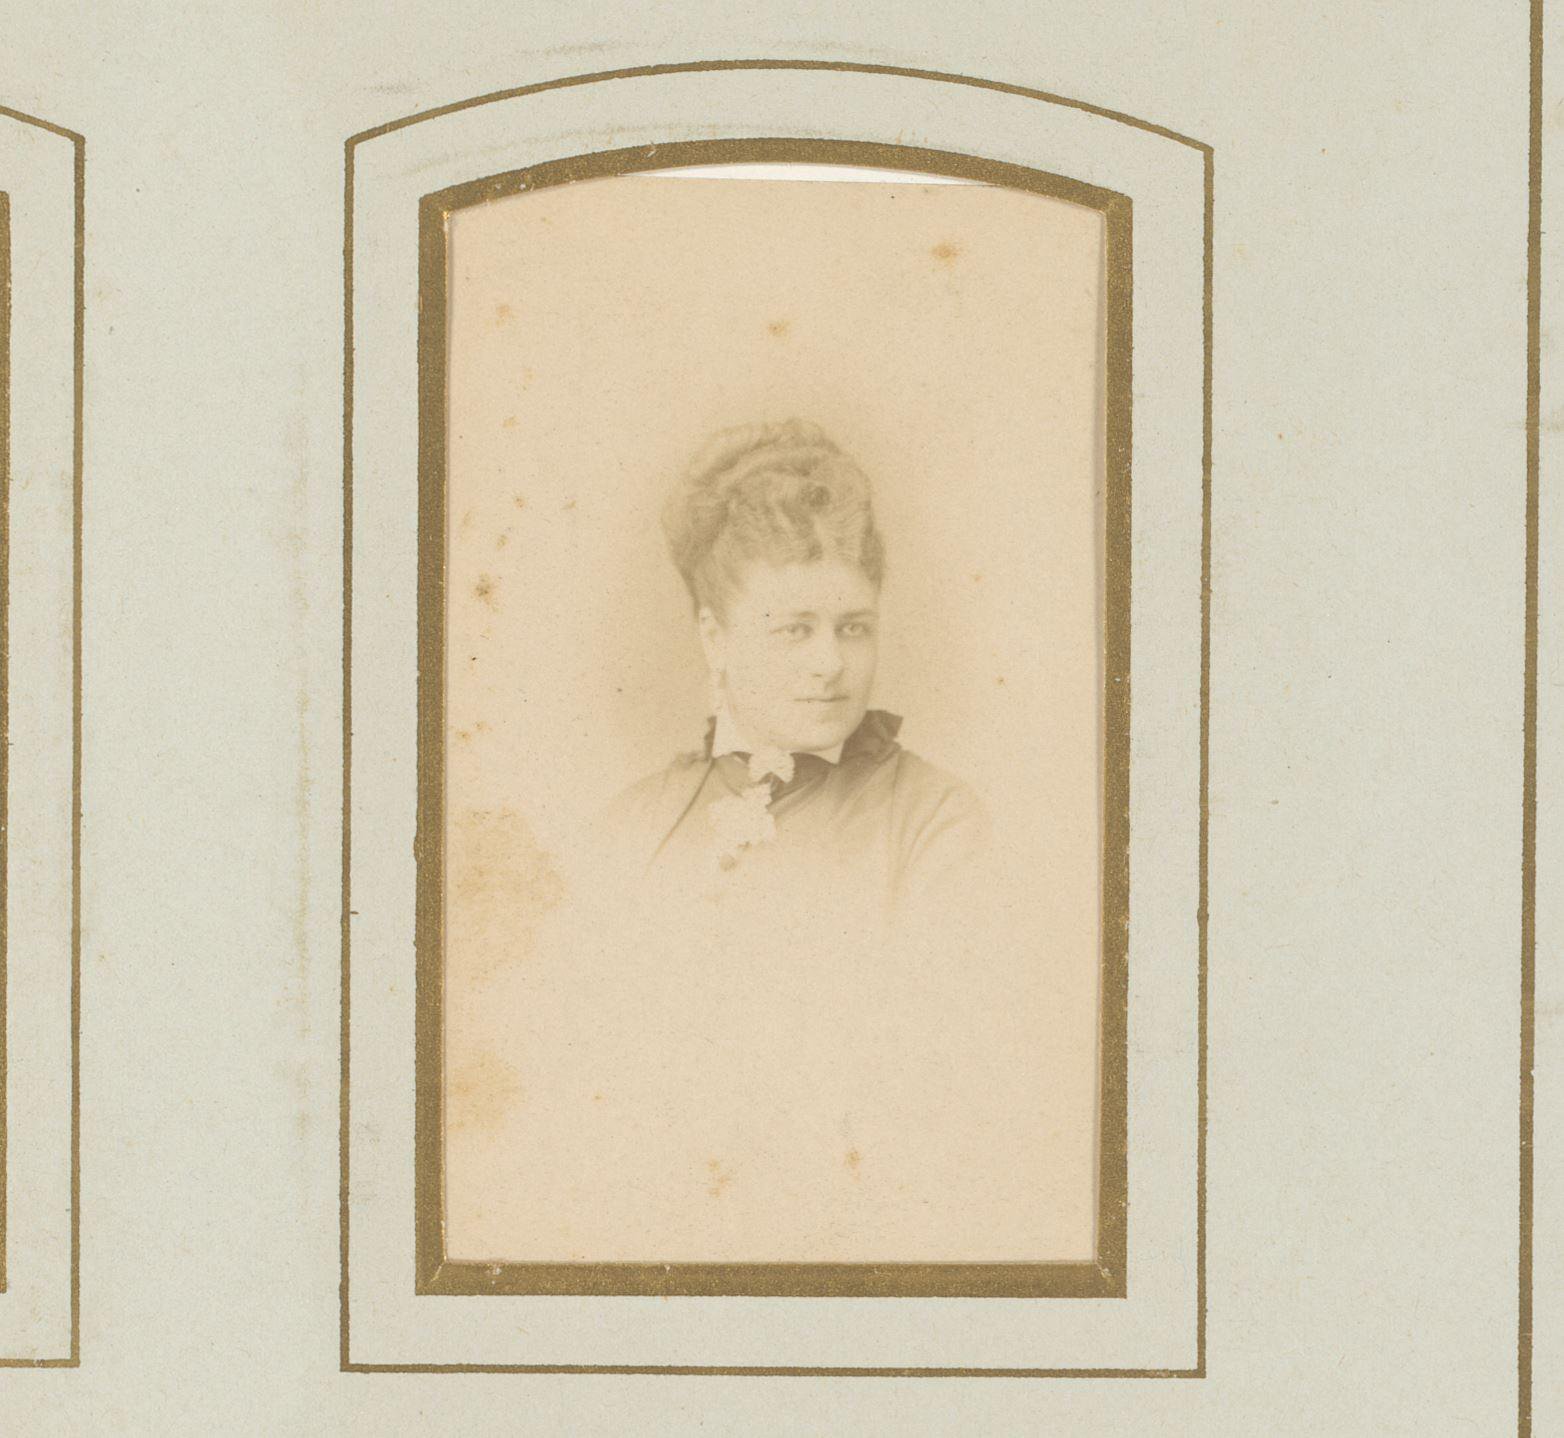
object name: photograph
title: Portret van een vrouw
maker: tony rouge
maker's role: fotograaf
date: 1850-1900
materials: cardboard, photographic support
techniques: albumen print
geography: paris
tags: historical persons - bb - woman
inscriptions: inscription: ‘[...]/ Jules DESREZ Succr/ de/ TONY ROUGE/ 36, Rue Vivienne, 36/ Paris./ A[...] PORT[...]/ Tous les Clichés sont conservés [...]/ des épreuves agrandies jusqu[...]/ nature sans avoir à poser de no[...]’